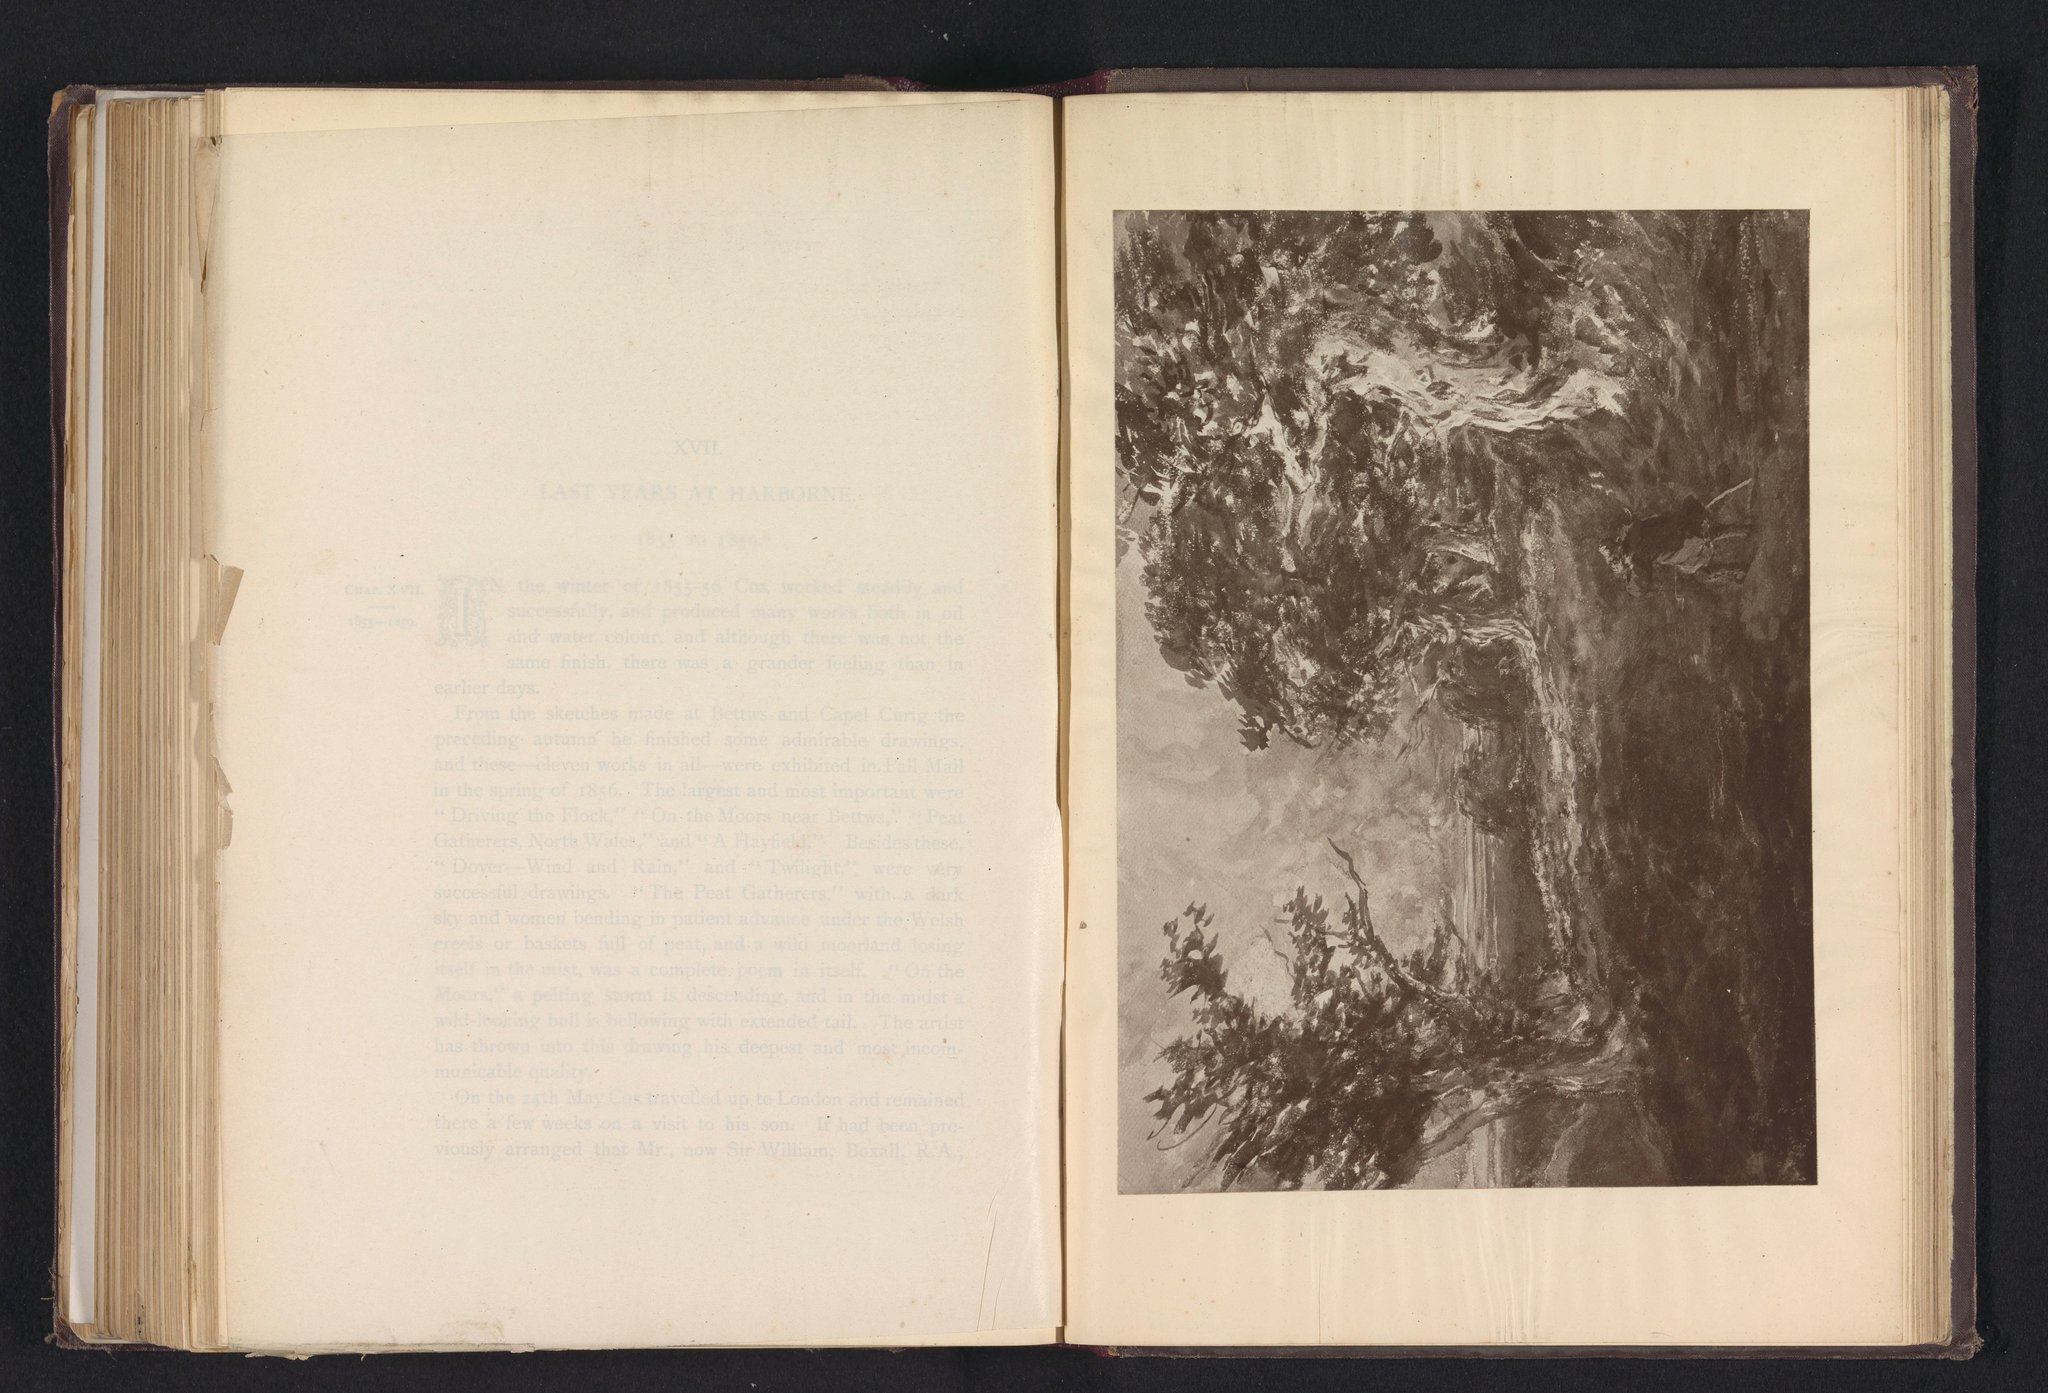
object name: page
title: Fotoreproductie van een tekening van het Sherwood Forest met een persoon door David Cox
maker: Anonymous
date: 1863-1873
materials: paper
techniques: woodburytype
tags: drawing, sketch, forest, wood